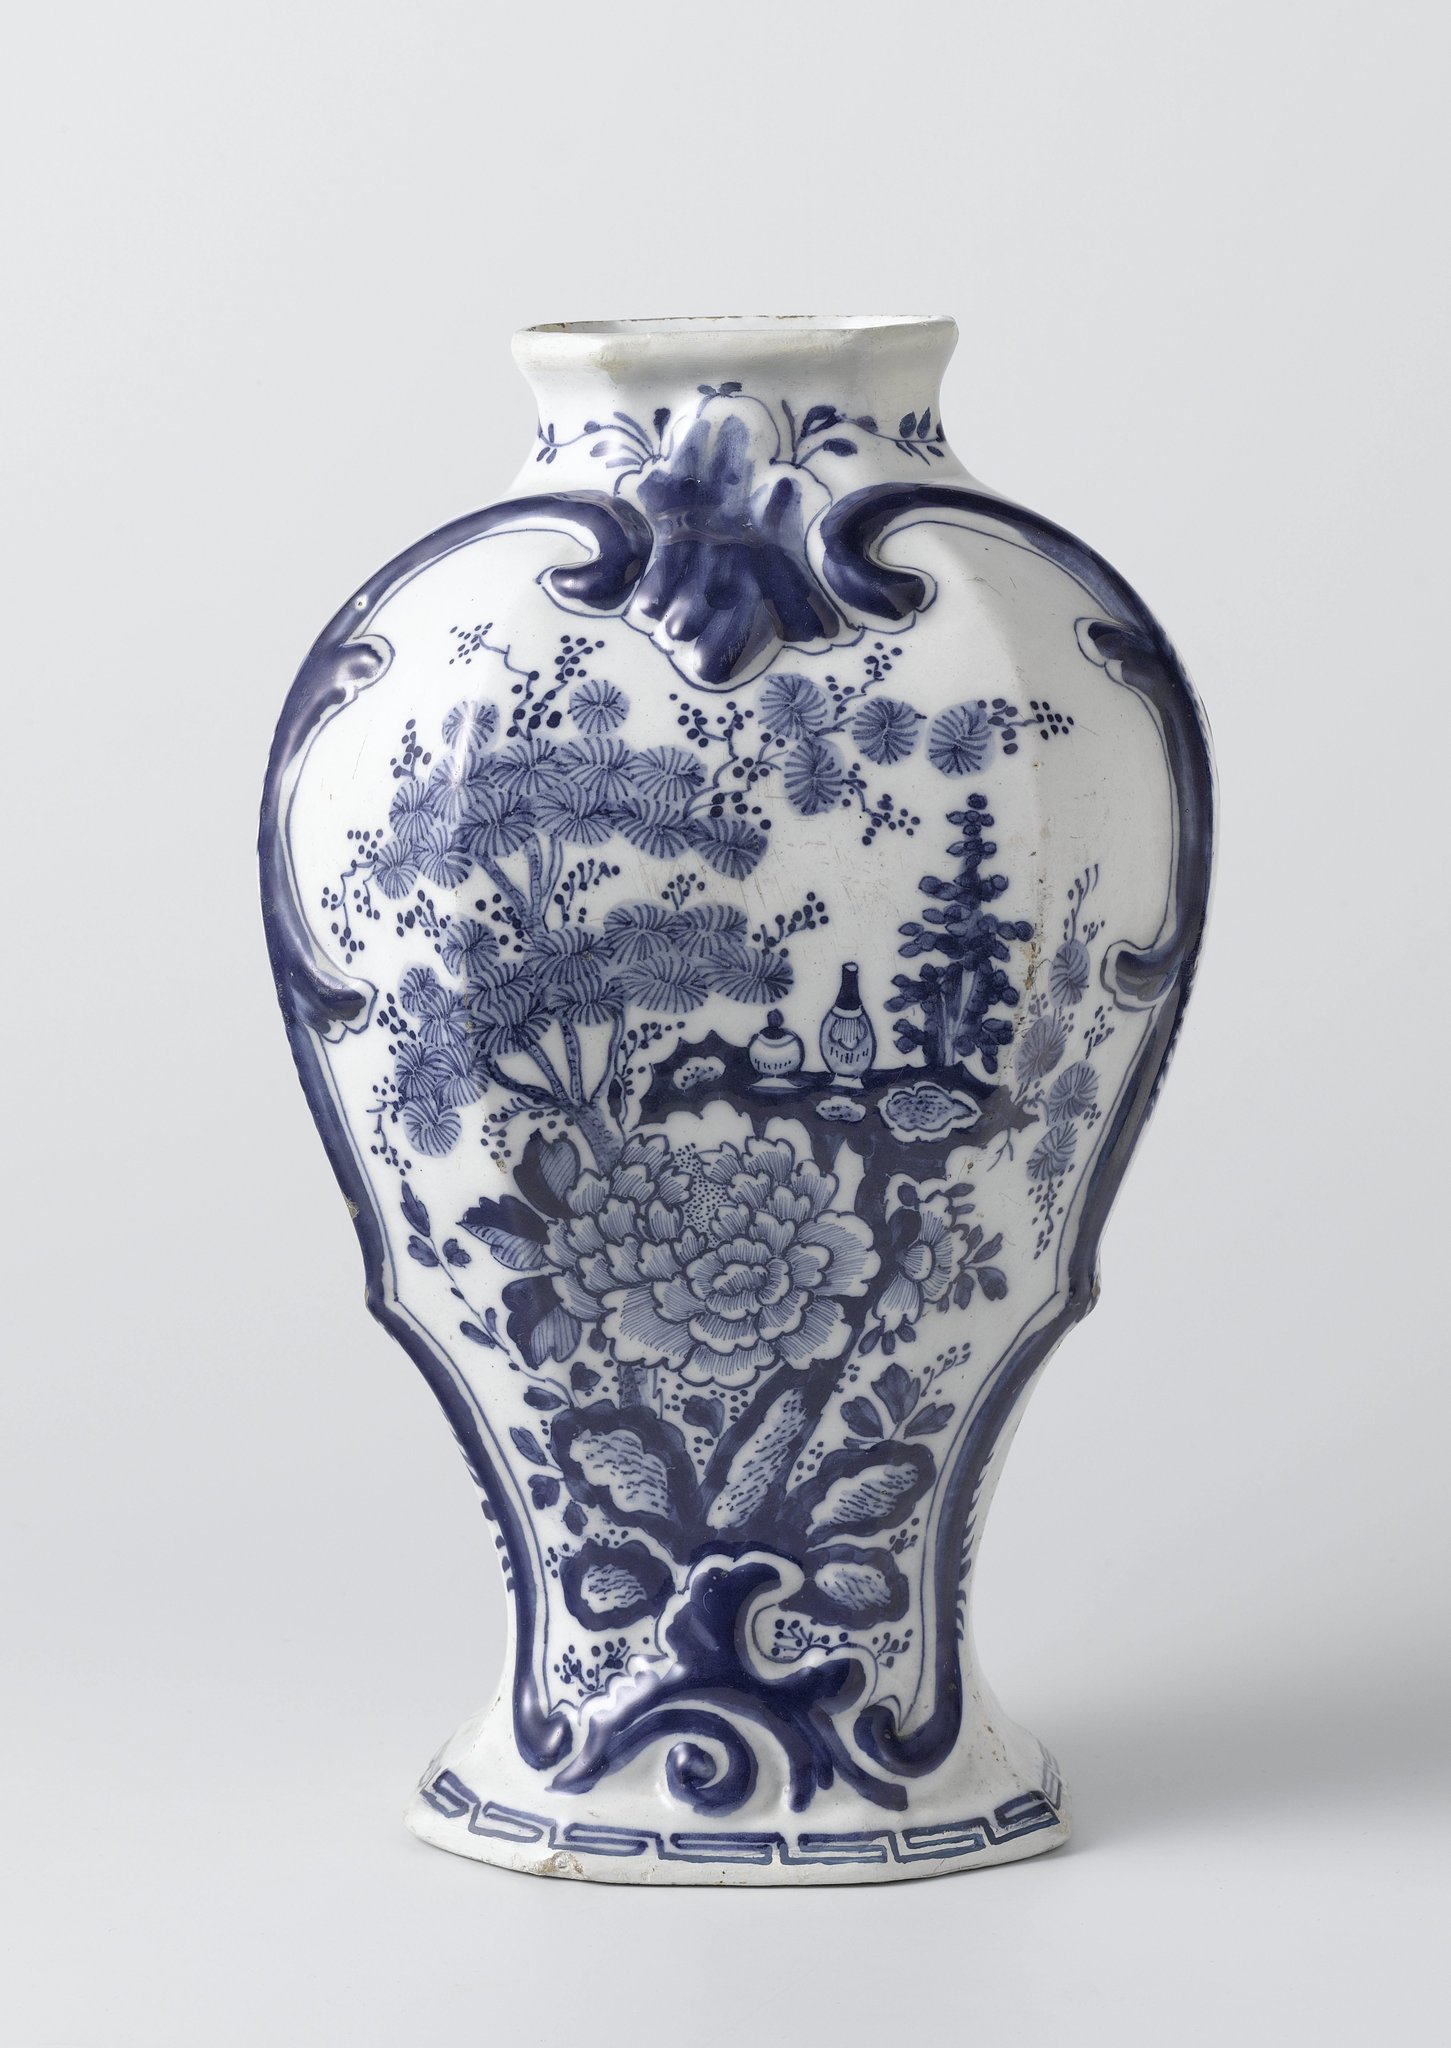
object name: kaststel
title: Two beaker vases and a vase, part of a garniture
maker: lambertus sanderus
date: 1760-1800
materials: faience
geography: delft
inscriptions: mark: ‘figuratief teken klauw/ 22 0/2 0’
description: attributed to De Klaauw (Lambertus Sanderus) Delft, c. 1760–1800 tin-glazed earthenware (faience)